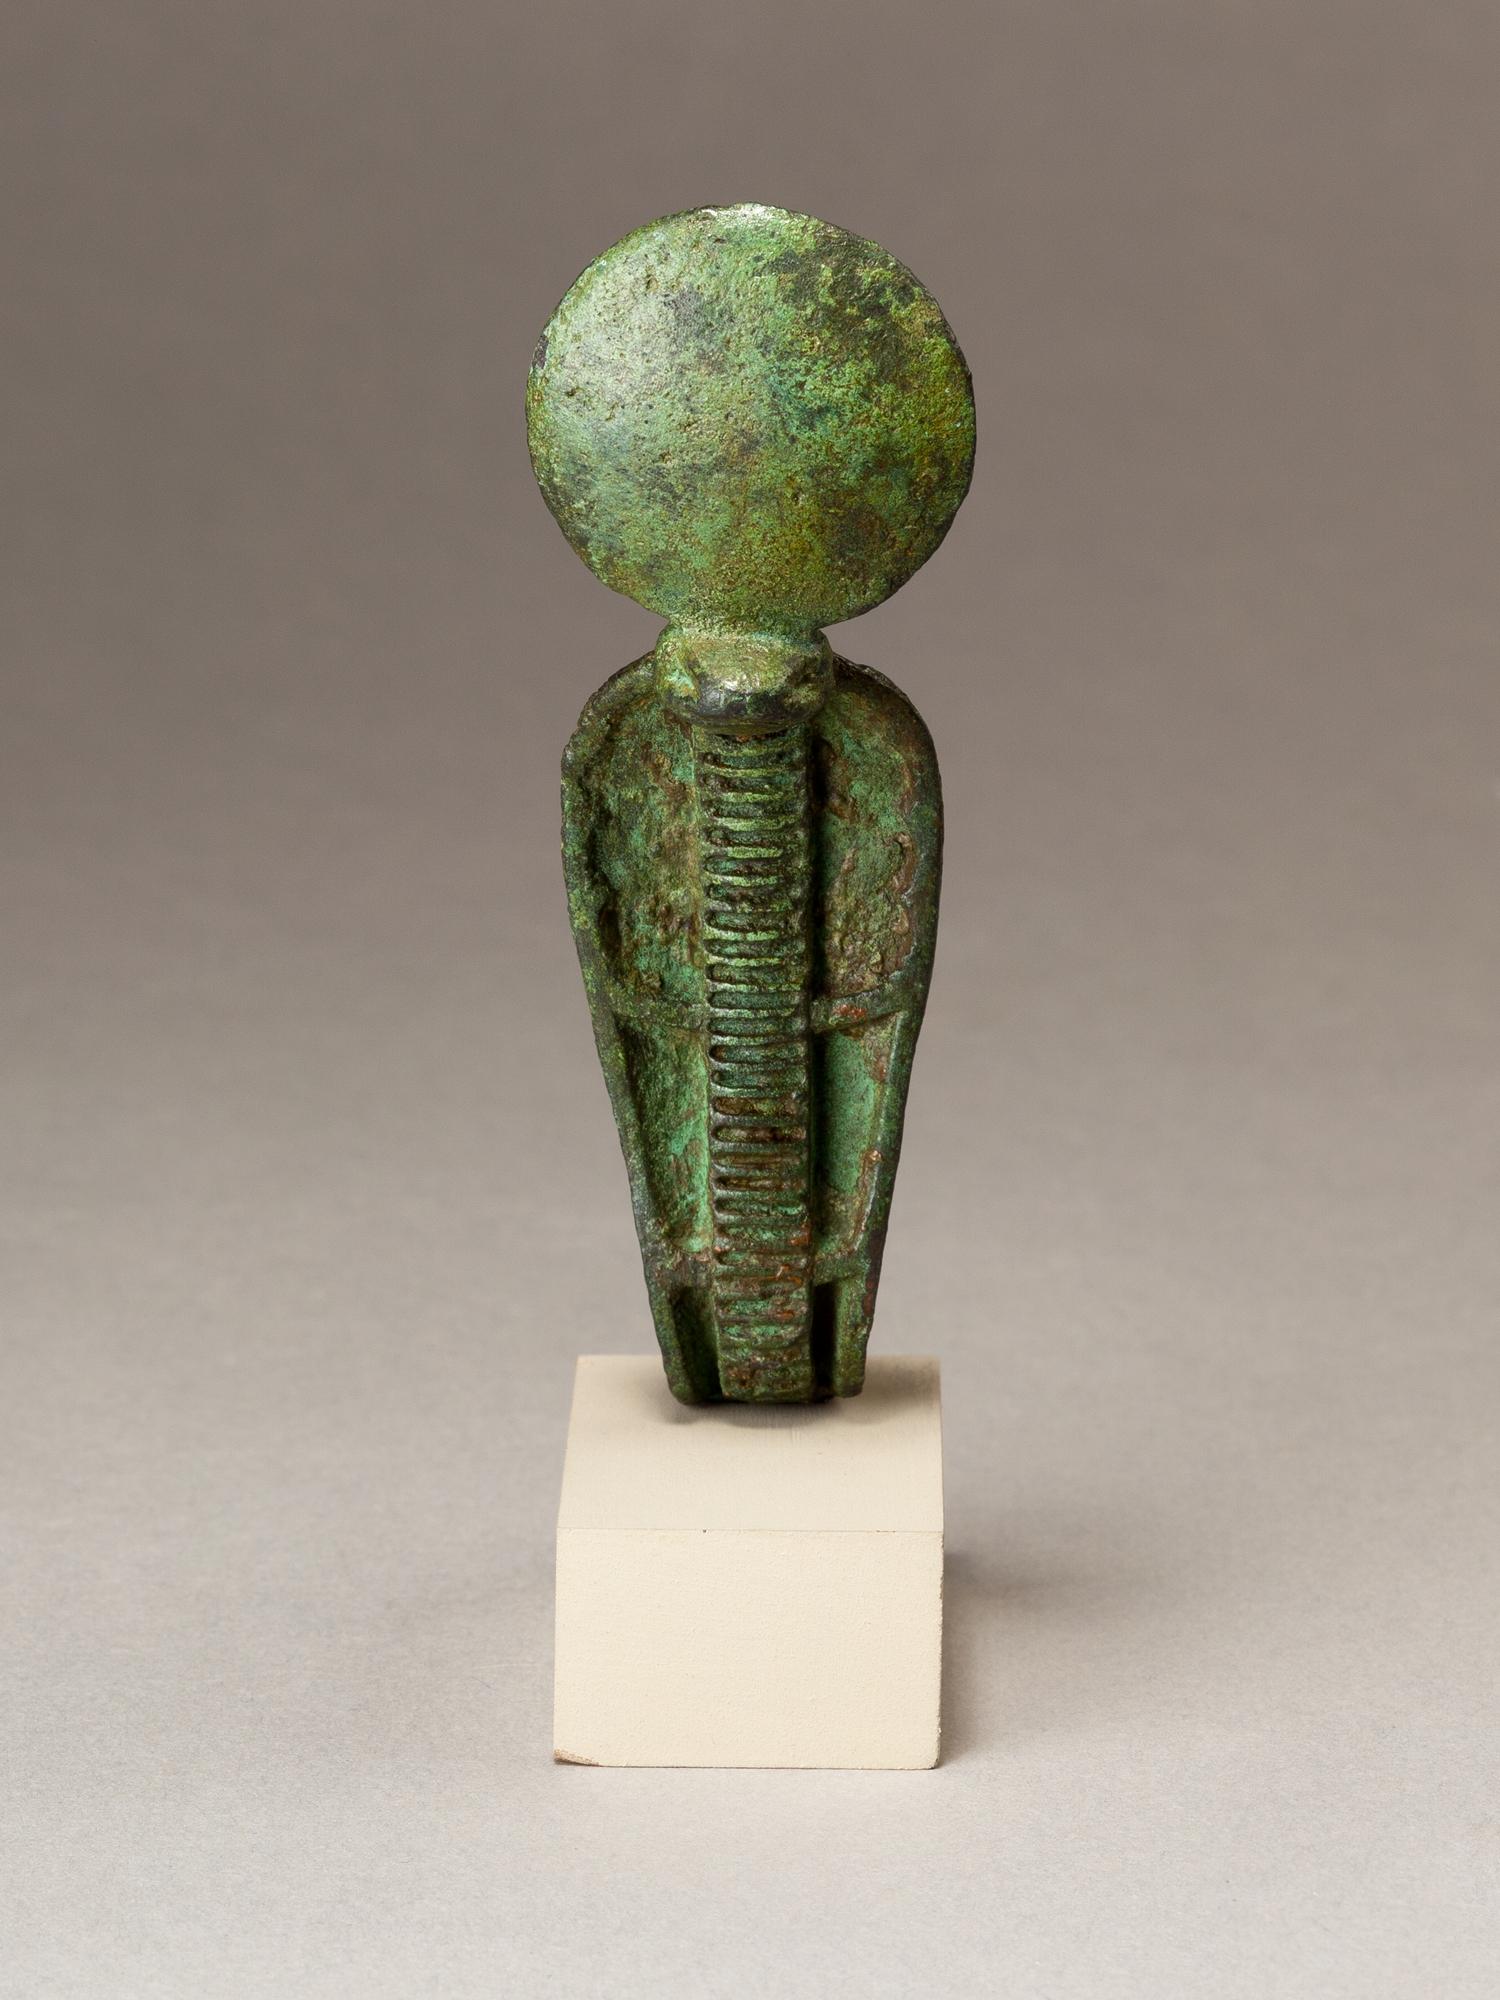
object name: figurine, uraeus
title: Uraeus fitting from shrine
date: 664-630 BCE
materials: metal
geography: egypt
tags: serpents